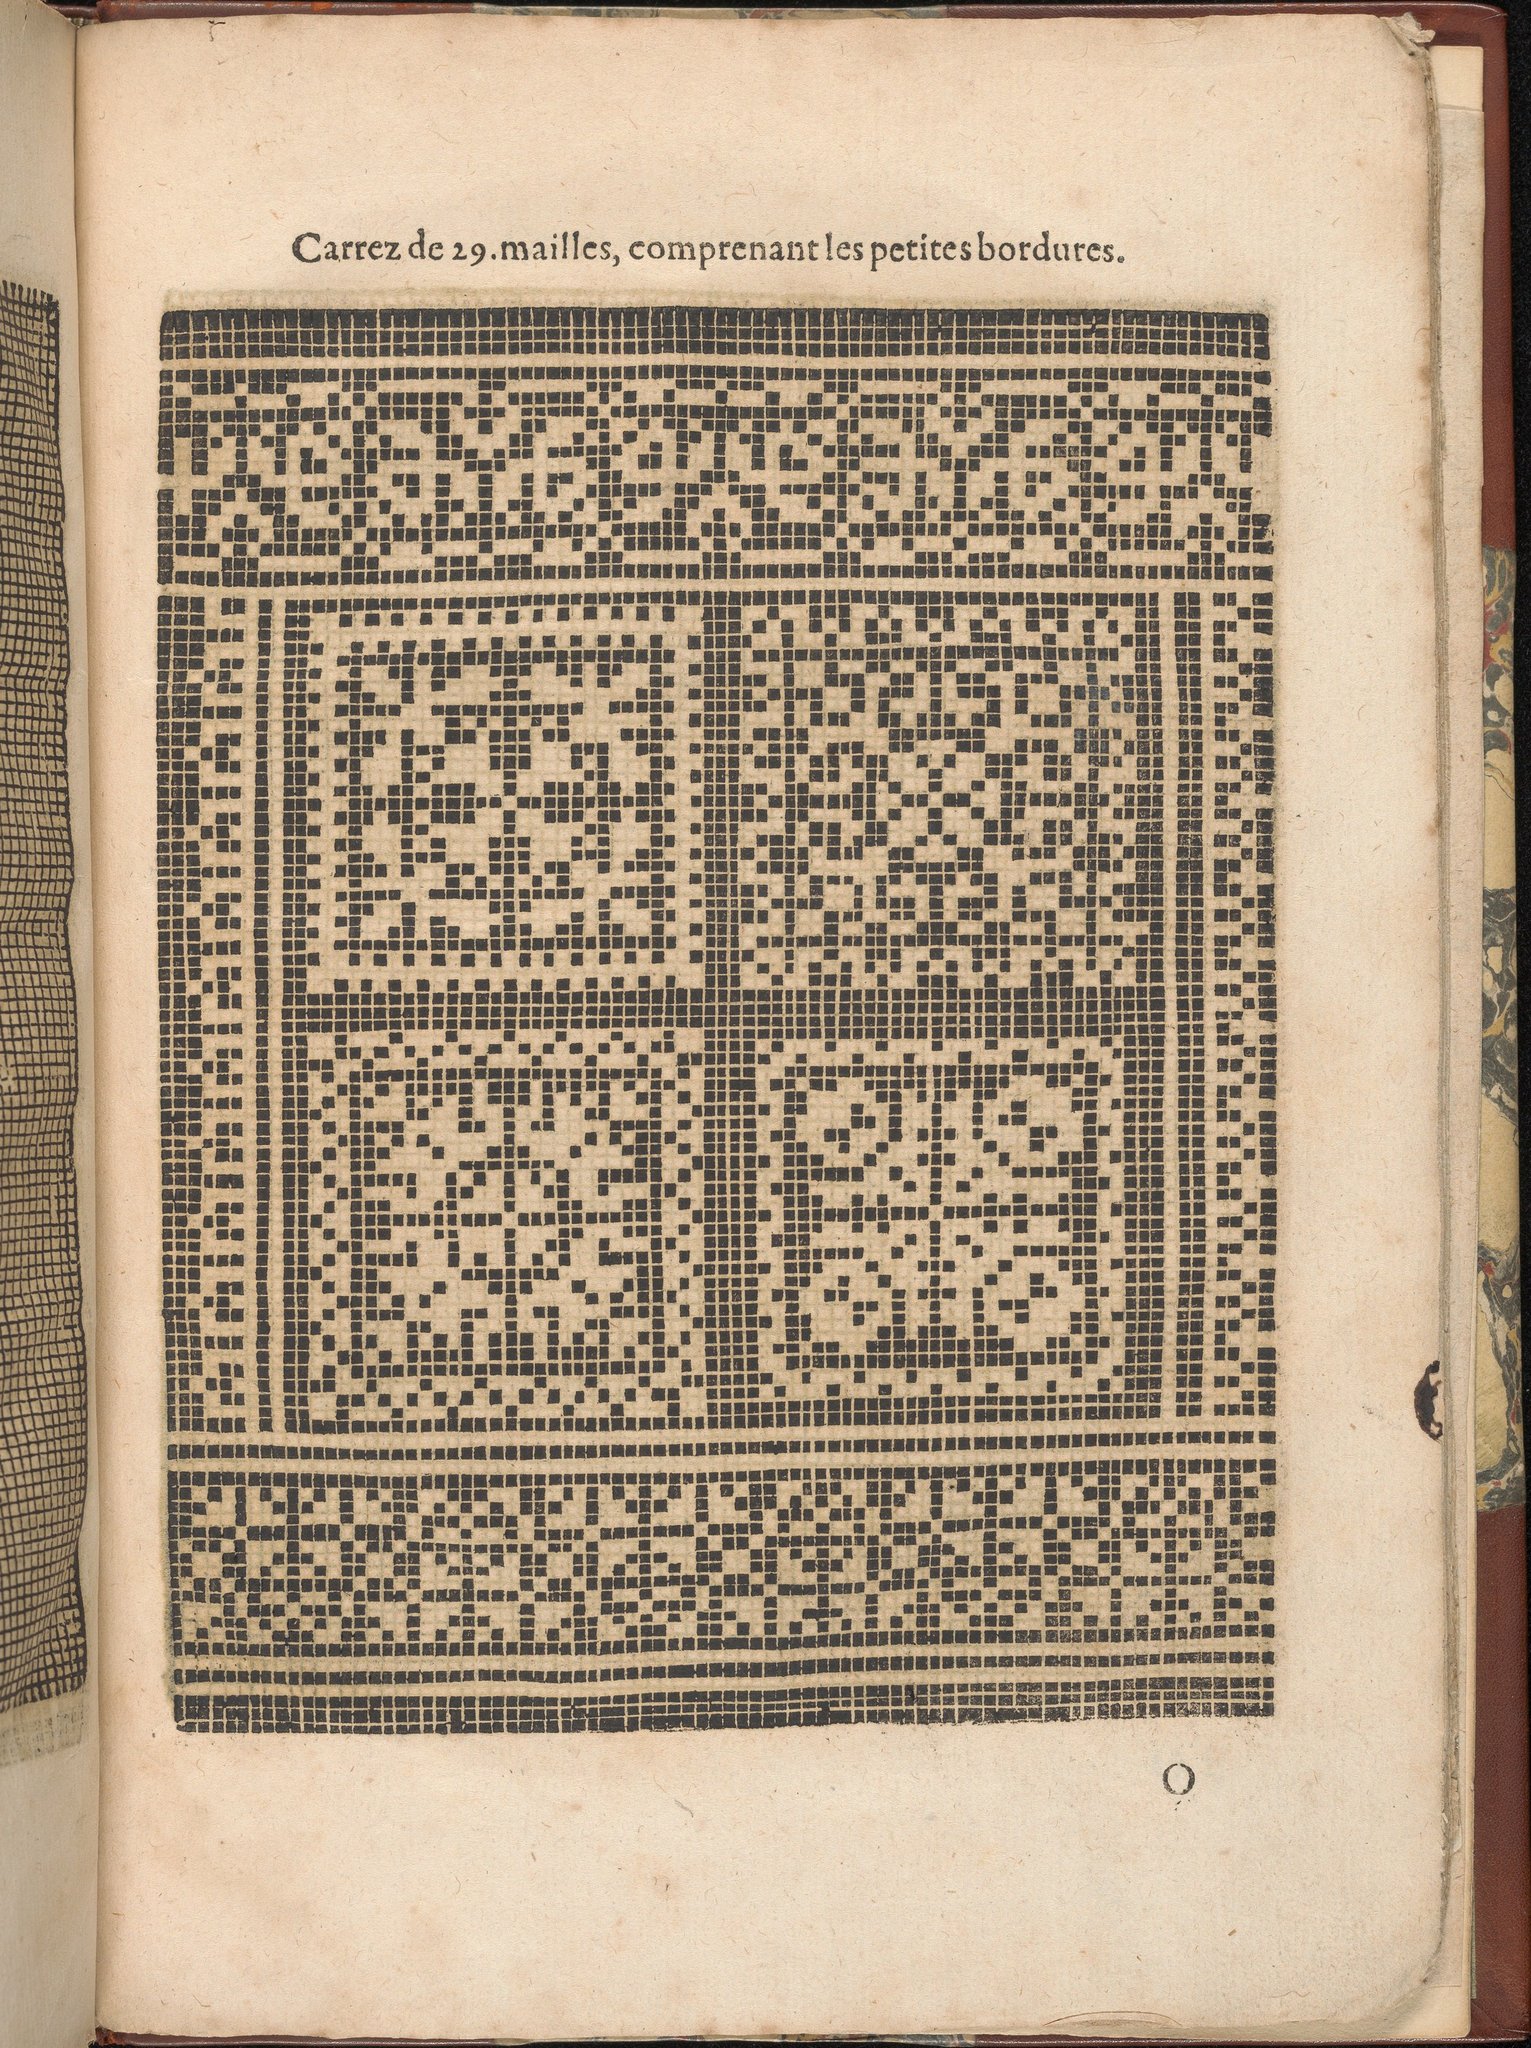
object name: book print ornament architecture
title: Les Secondes Oeuvres, et Subtiles Inventions De Lingerie du Seigneur Federic de Vinciolo Venitien, page 53 (recto)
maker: federico de vinciolo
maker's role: designer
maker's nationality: italian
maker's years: 1582-1599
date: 1603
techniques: woodcut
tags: ornament